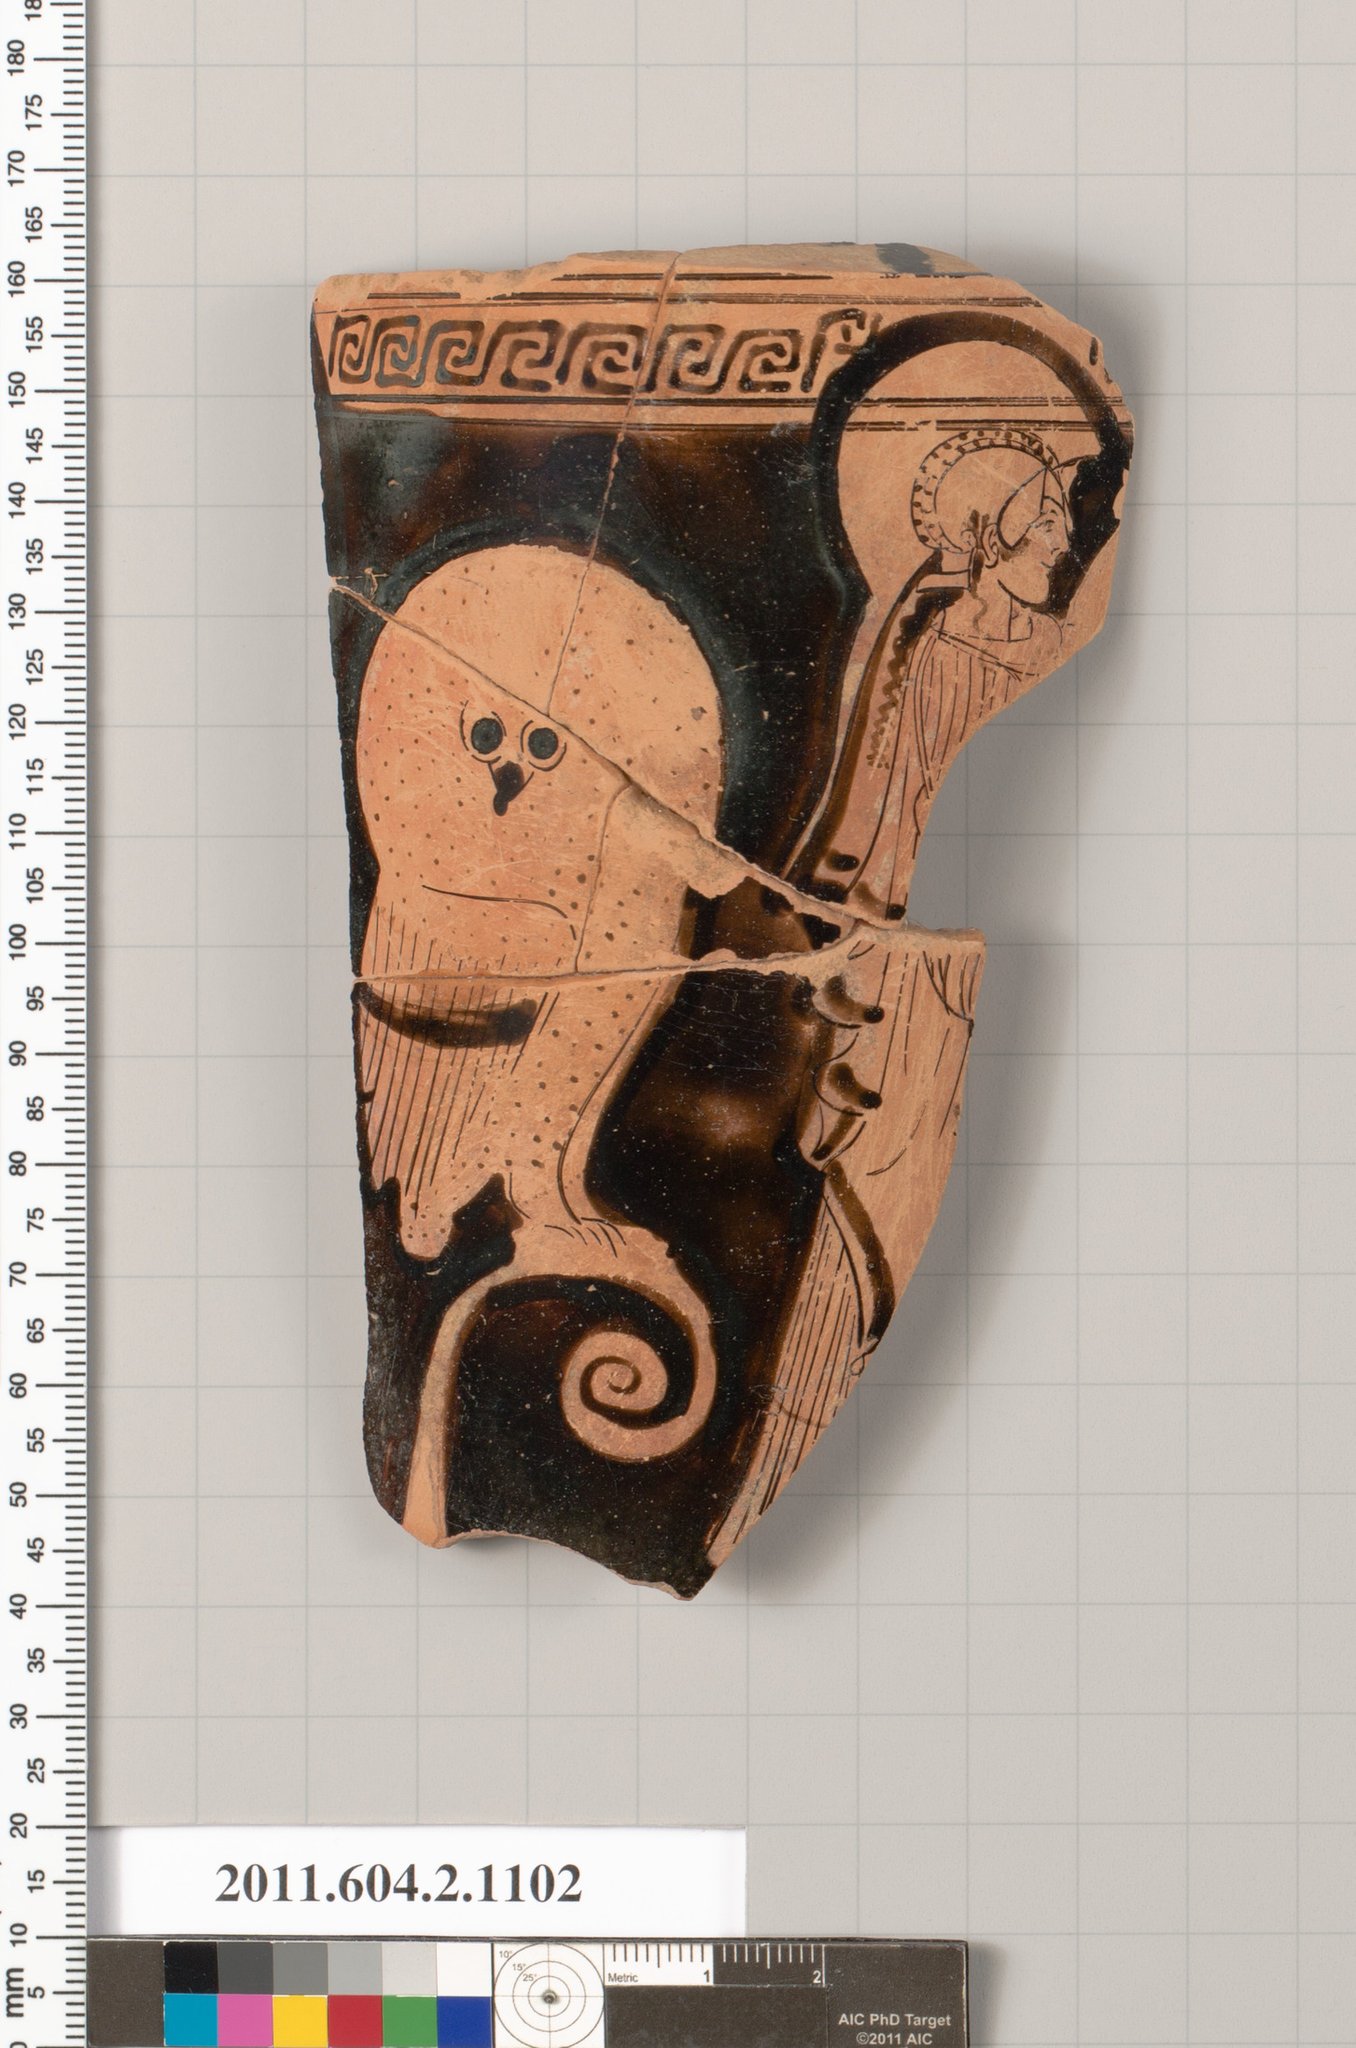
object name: lekythos fragment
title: Terracotta fragment of a lekythos (oil flask)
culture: greek, attic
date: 460-450 BCE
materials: terracotta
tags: owls